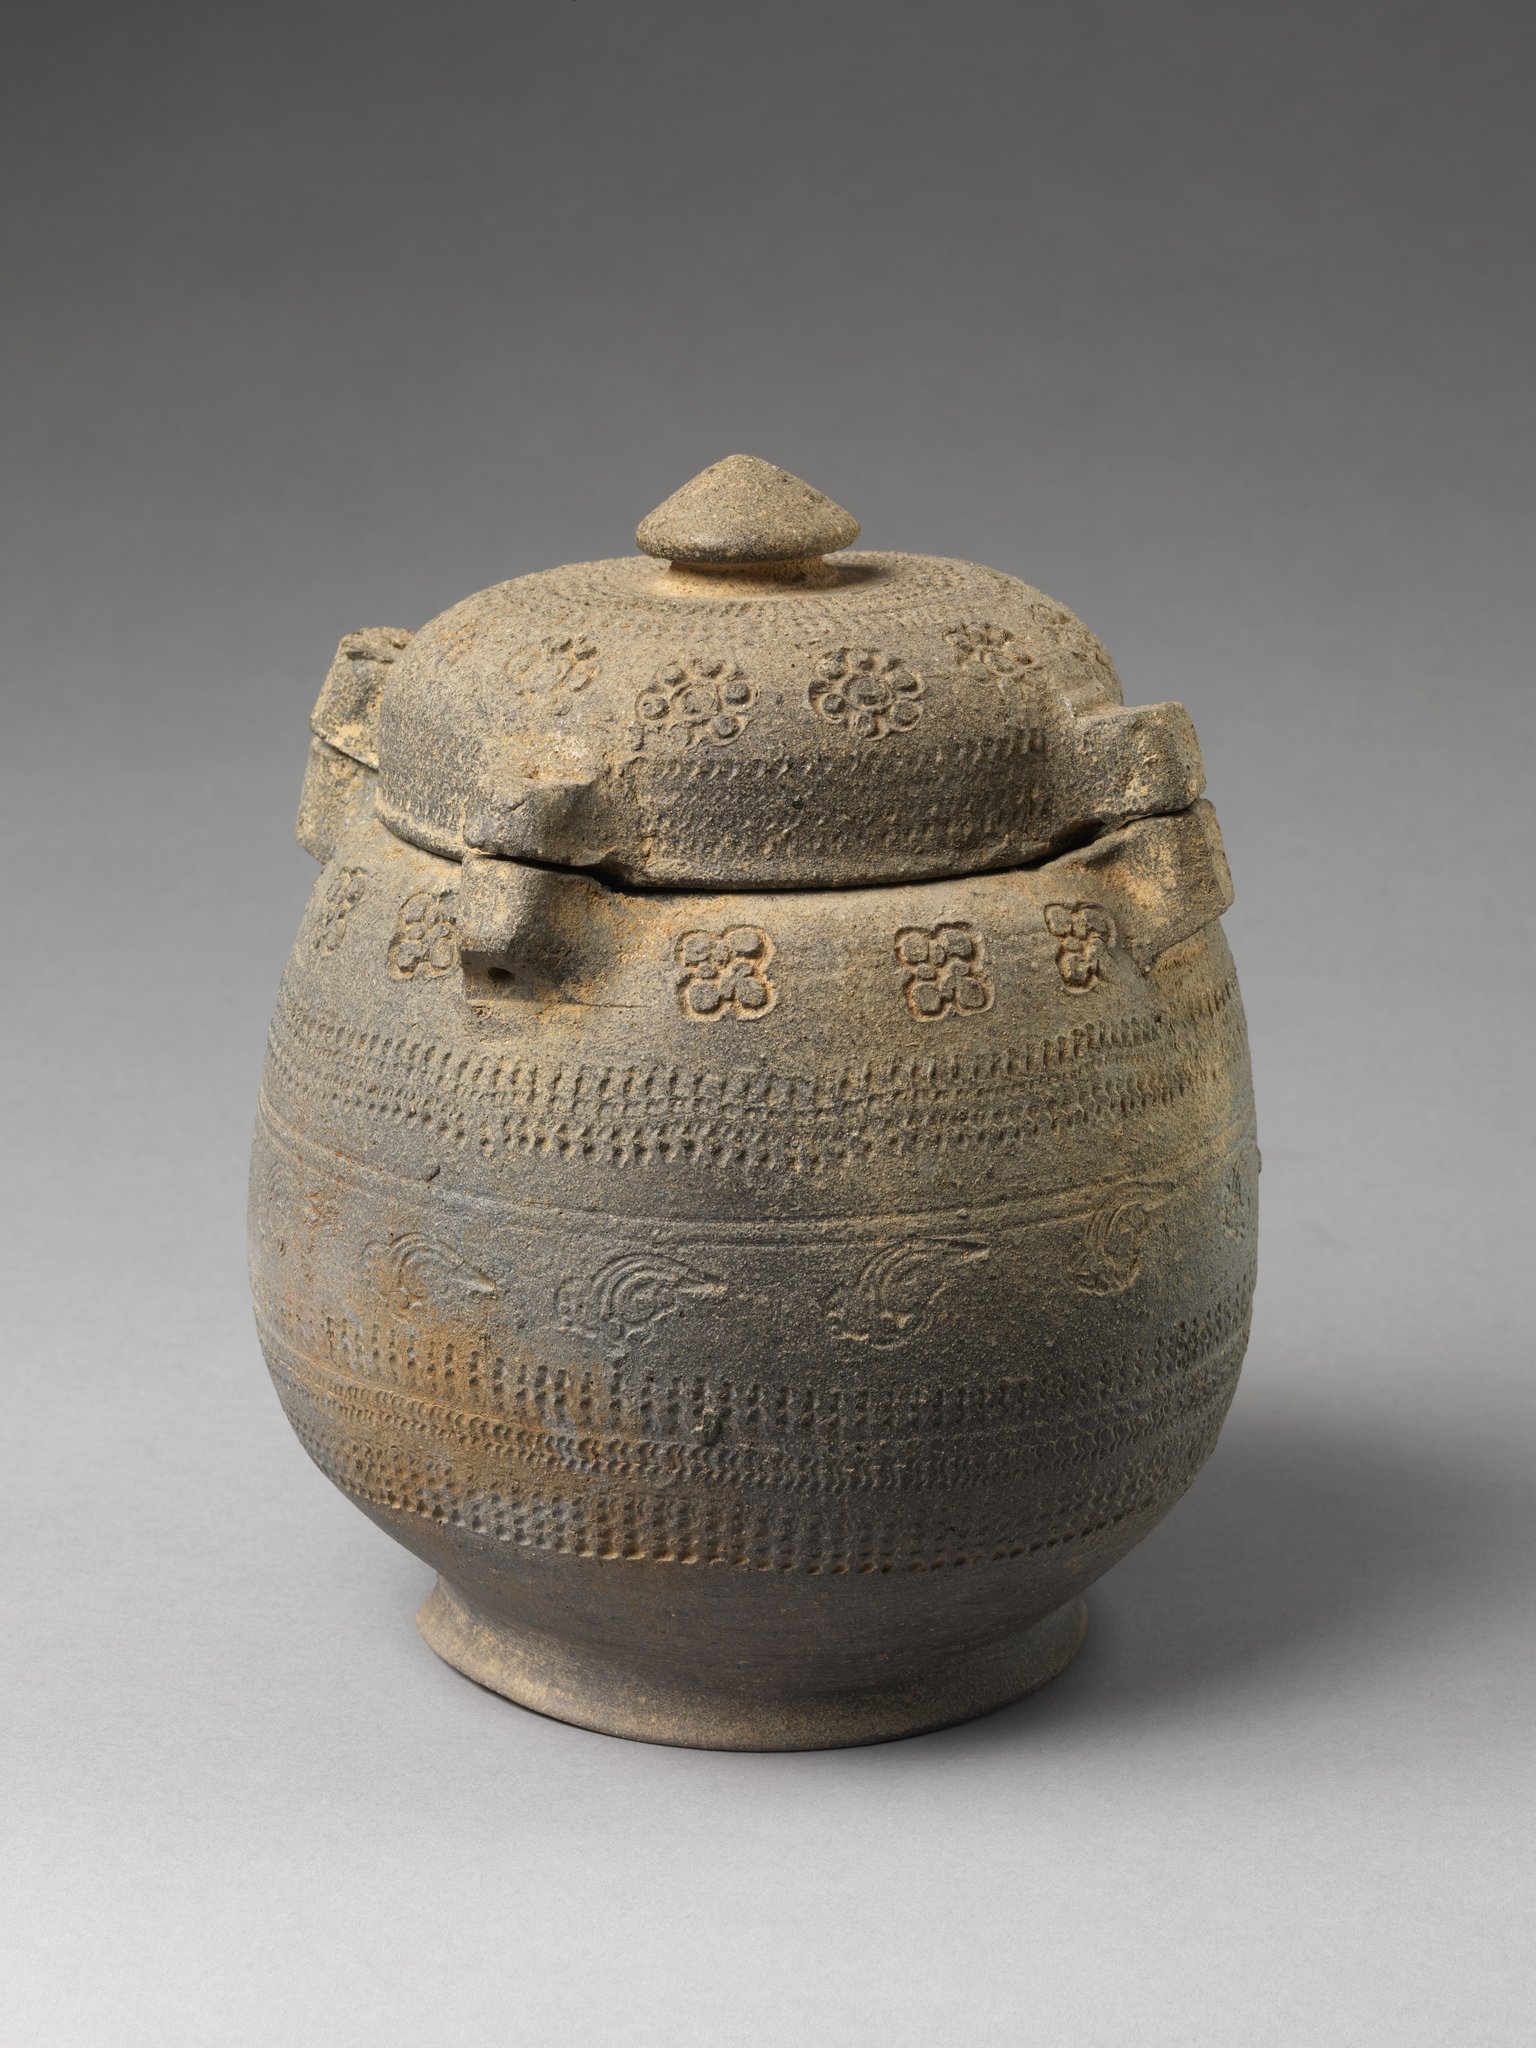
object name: urn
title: Covered urn with geometric decoration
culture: korean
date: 701-800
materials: stoneware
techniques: stamping